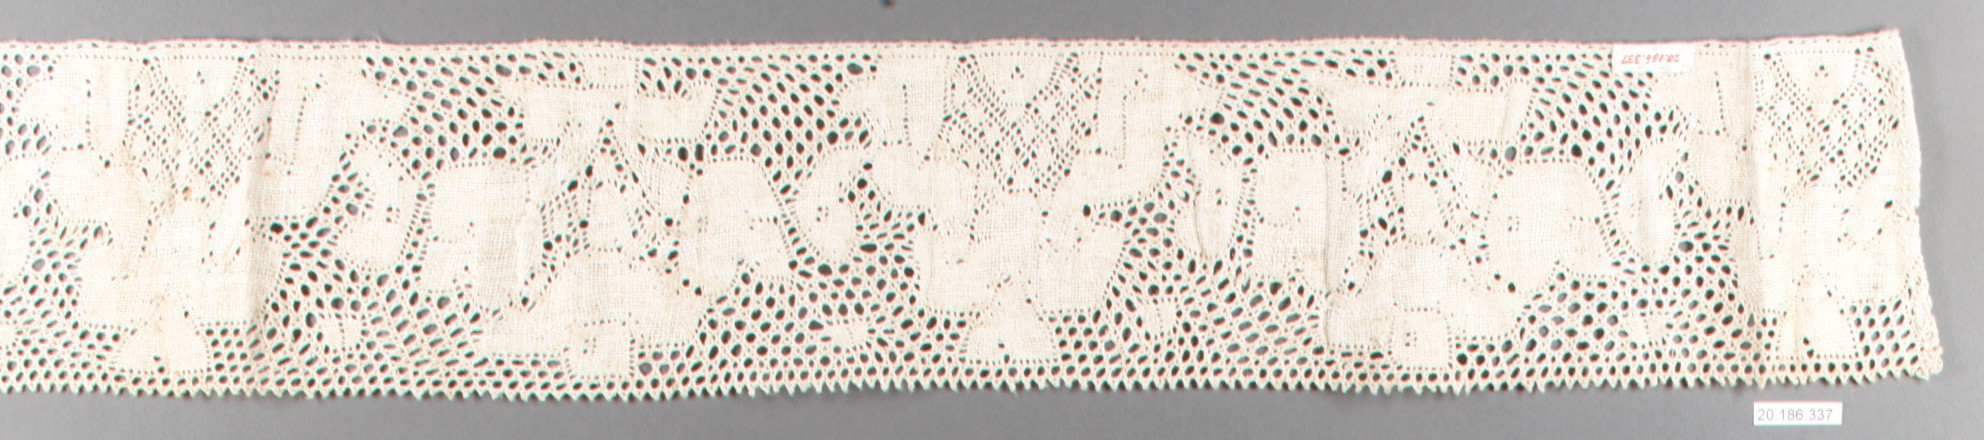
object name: edging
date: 1701-1800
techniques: lace